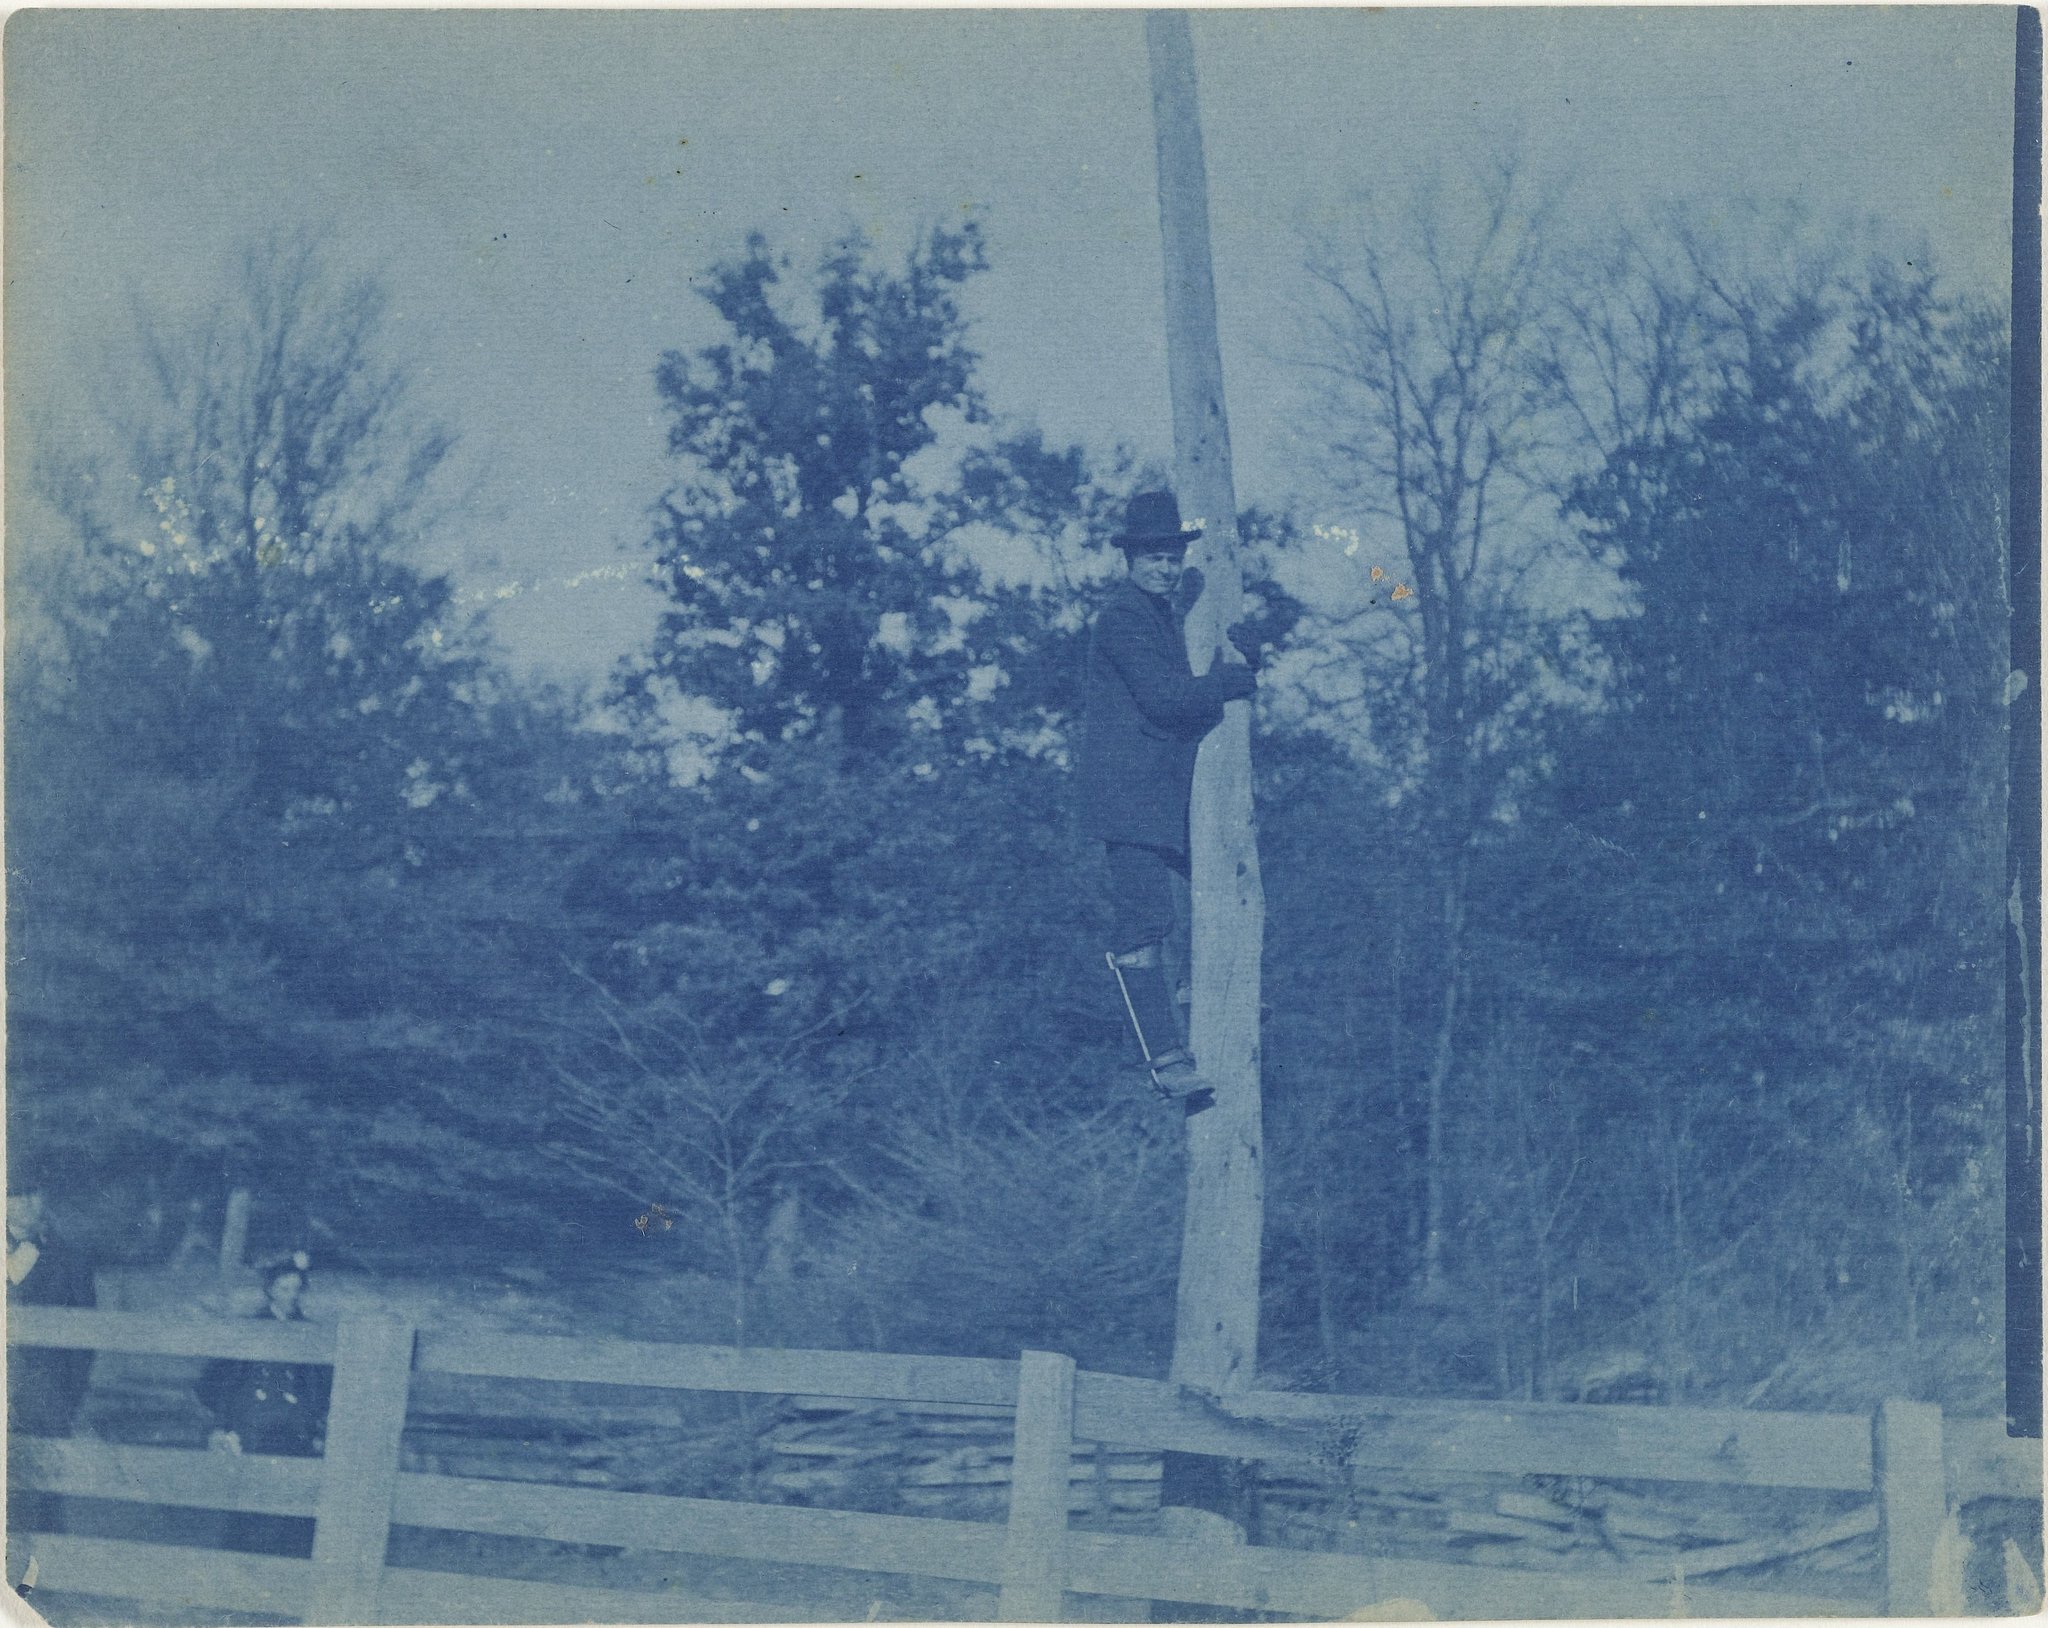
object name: photograph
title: Man die in een boom of paal is geklommen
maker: Anonymous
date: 1890-1920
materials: paper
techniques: cyanotype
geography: united states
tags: climbing up a tree